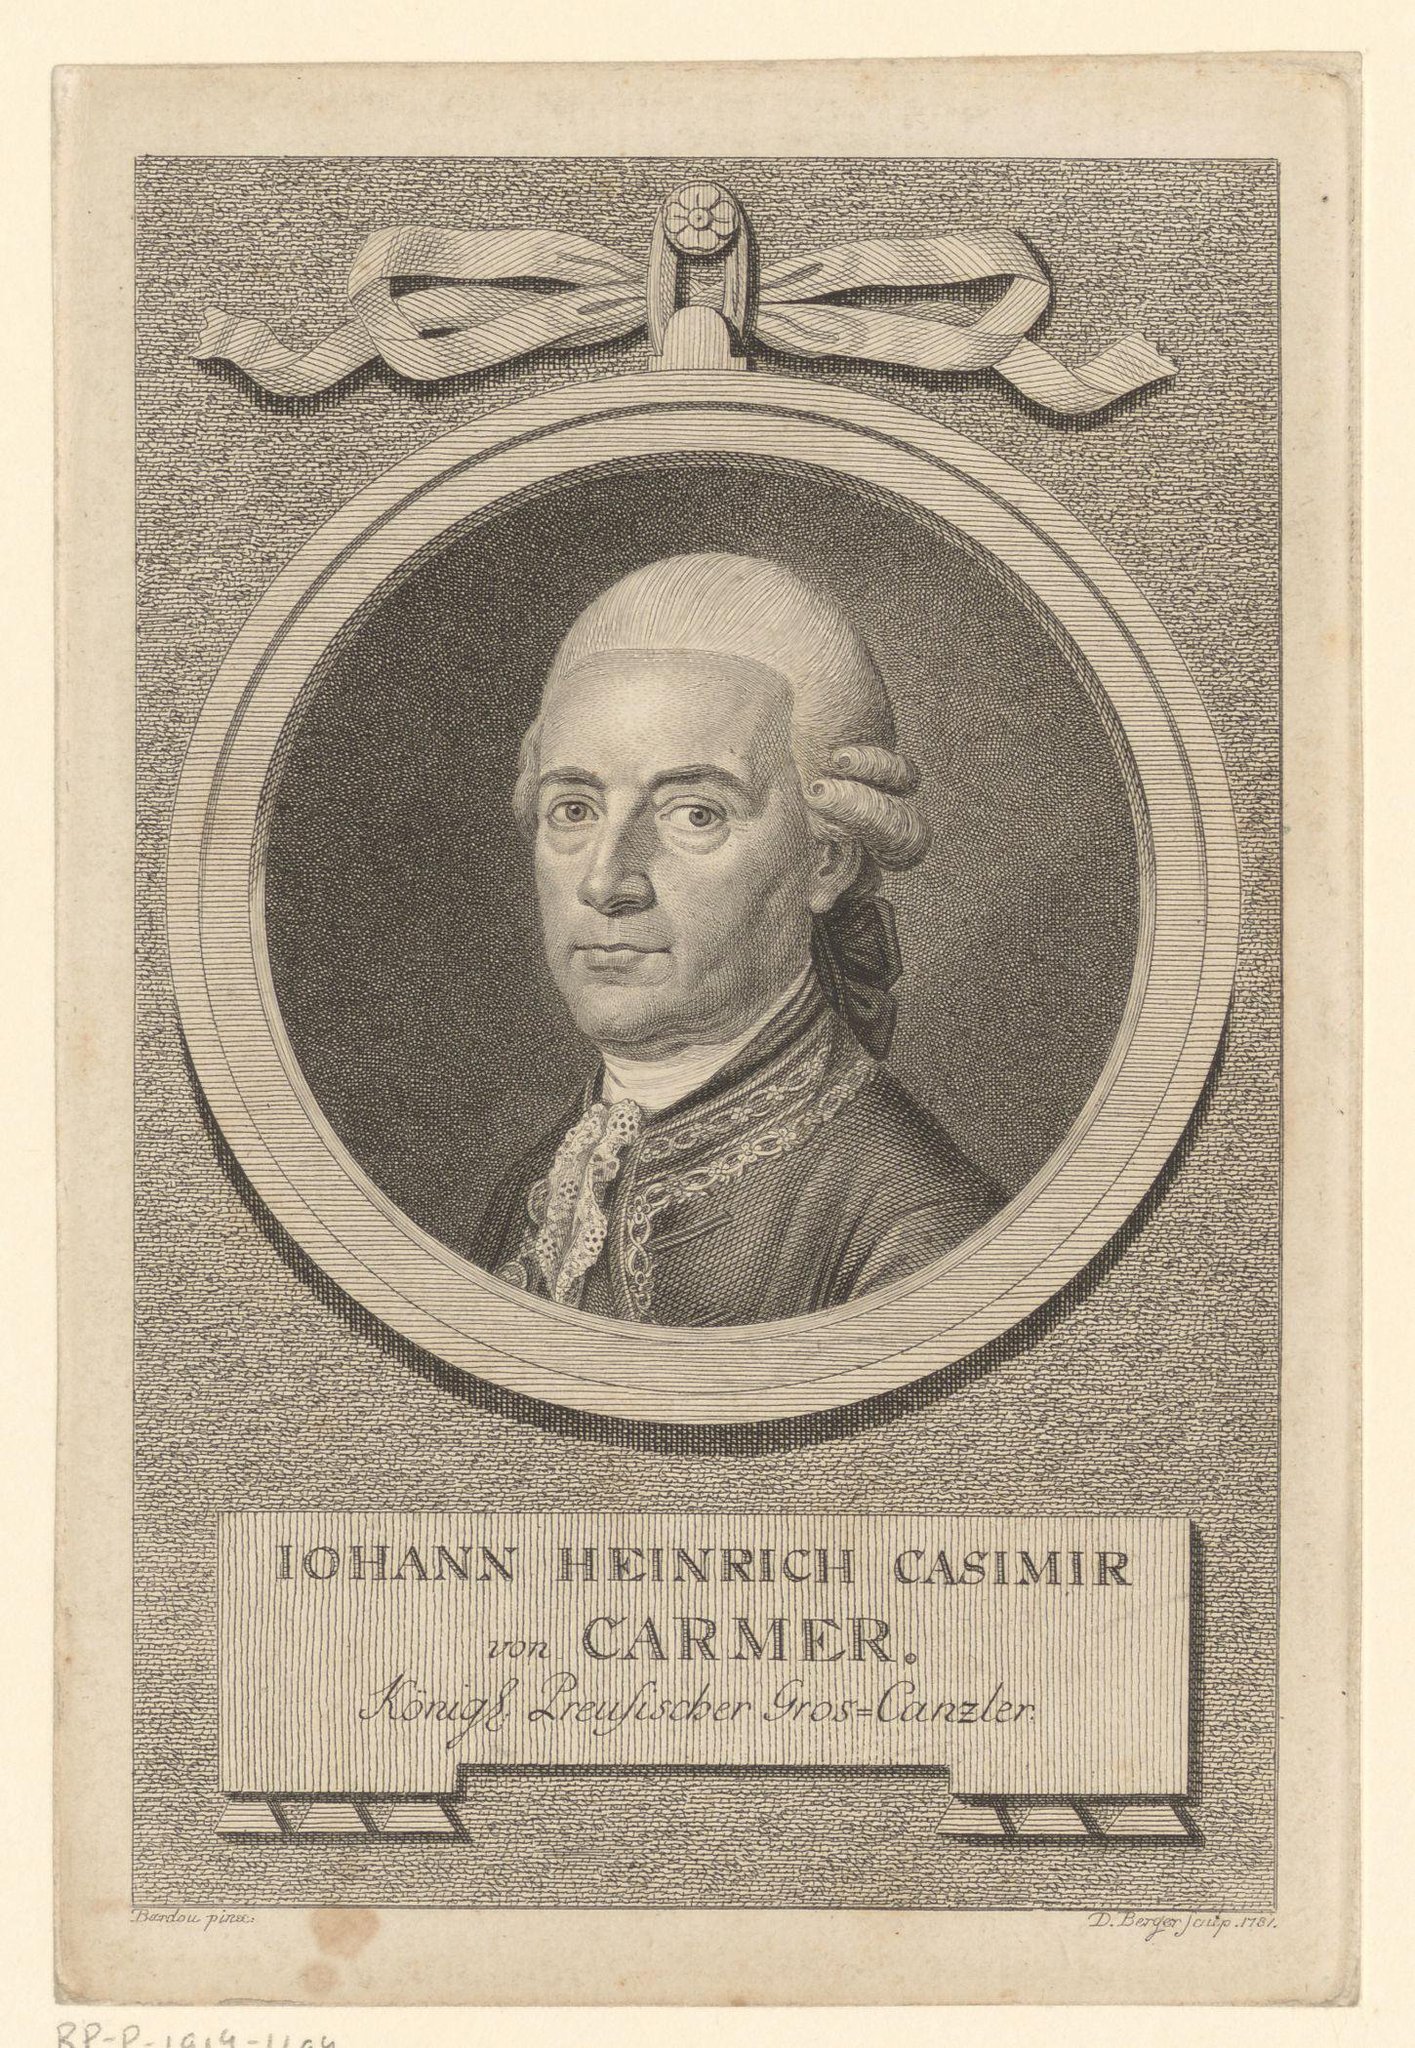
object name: print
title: Portret van Johann Heinrich Casimir von Carmer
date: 1781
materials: paper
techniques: engraving, etching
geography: berlin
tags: historical persons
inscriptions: collector's mark: Lugt 2228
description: Prent ook gebruikt in: Magazin der Gesetzgebung. dl. 1. Liegnitz en Leipzig: David Siegert, 1781.